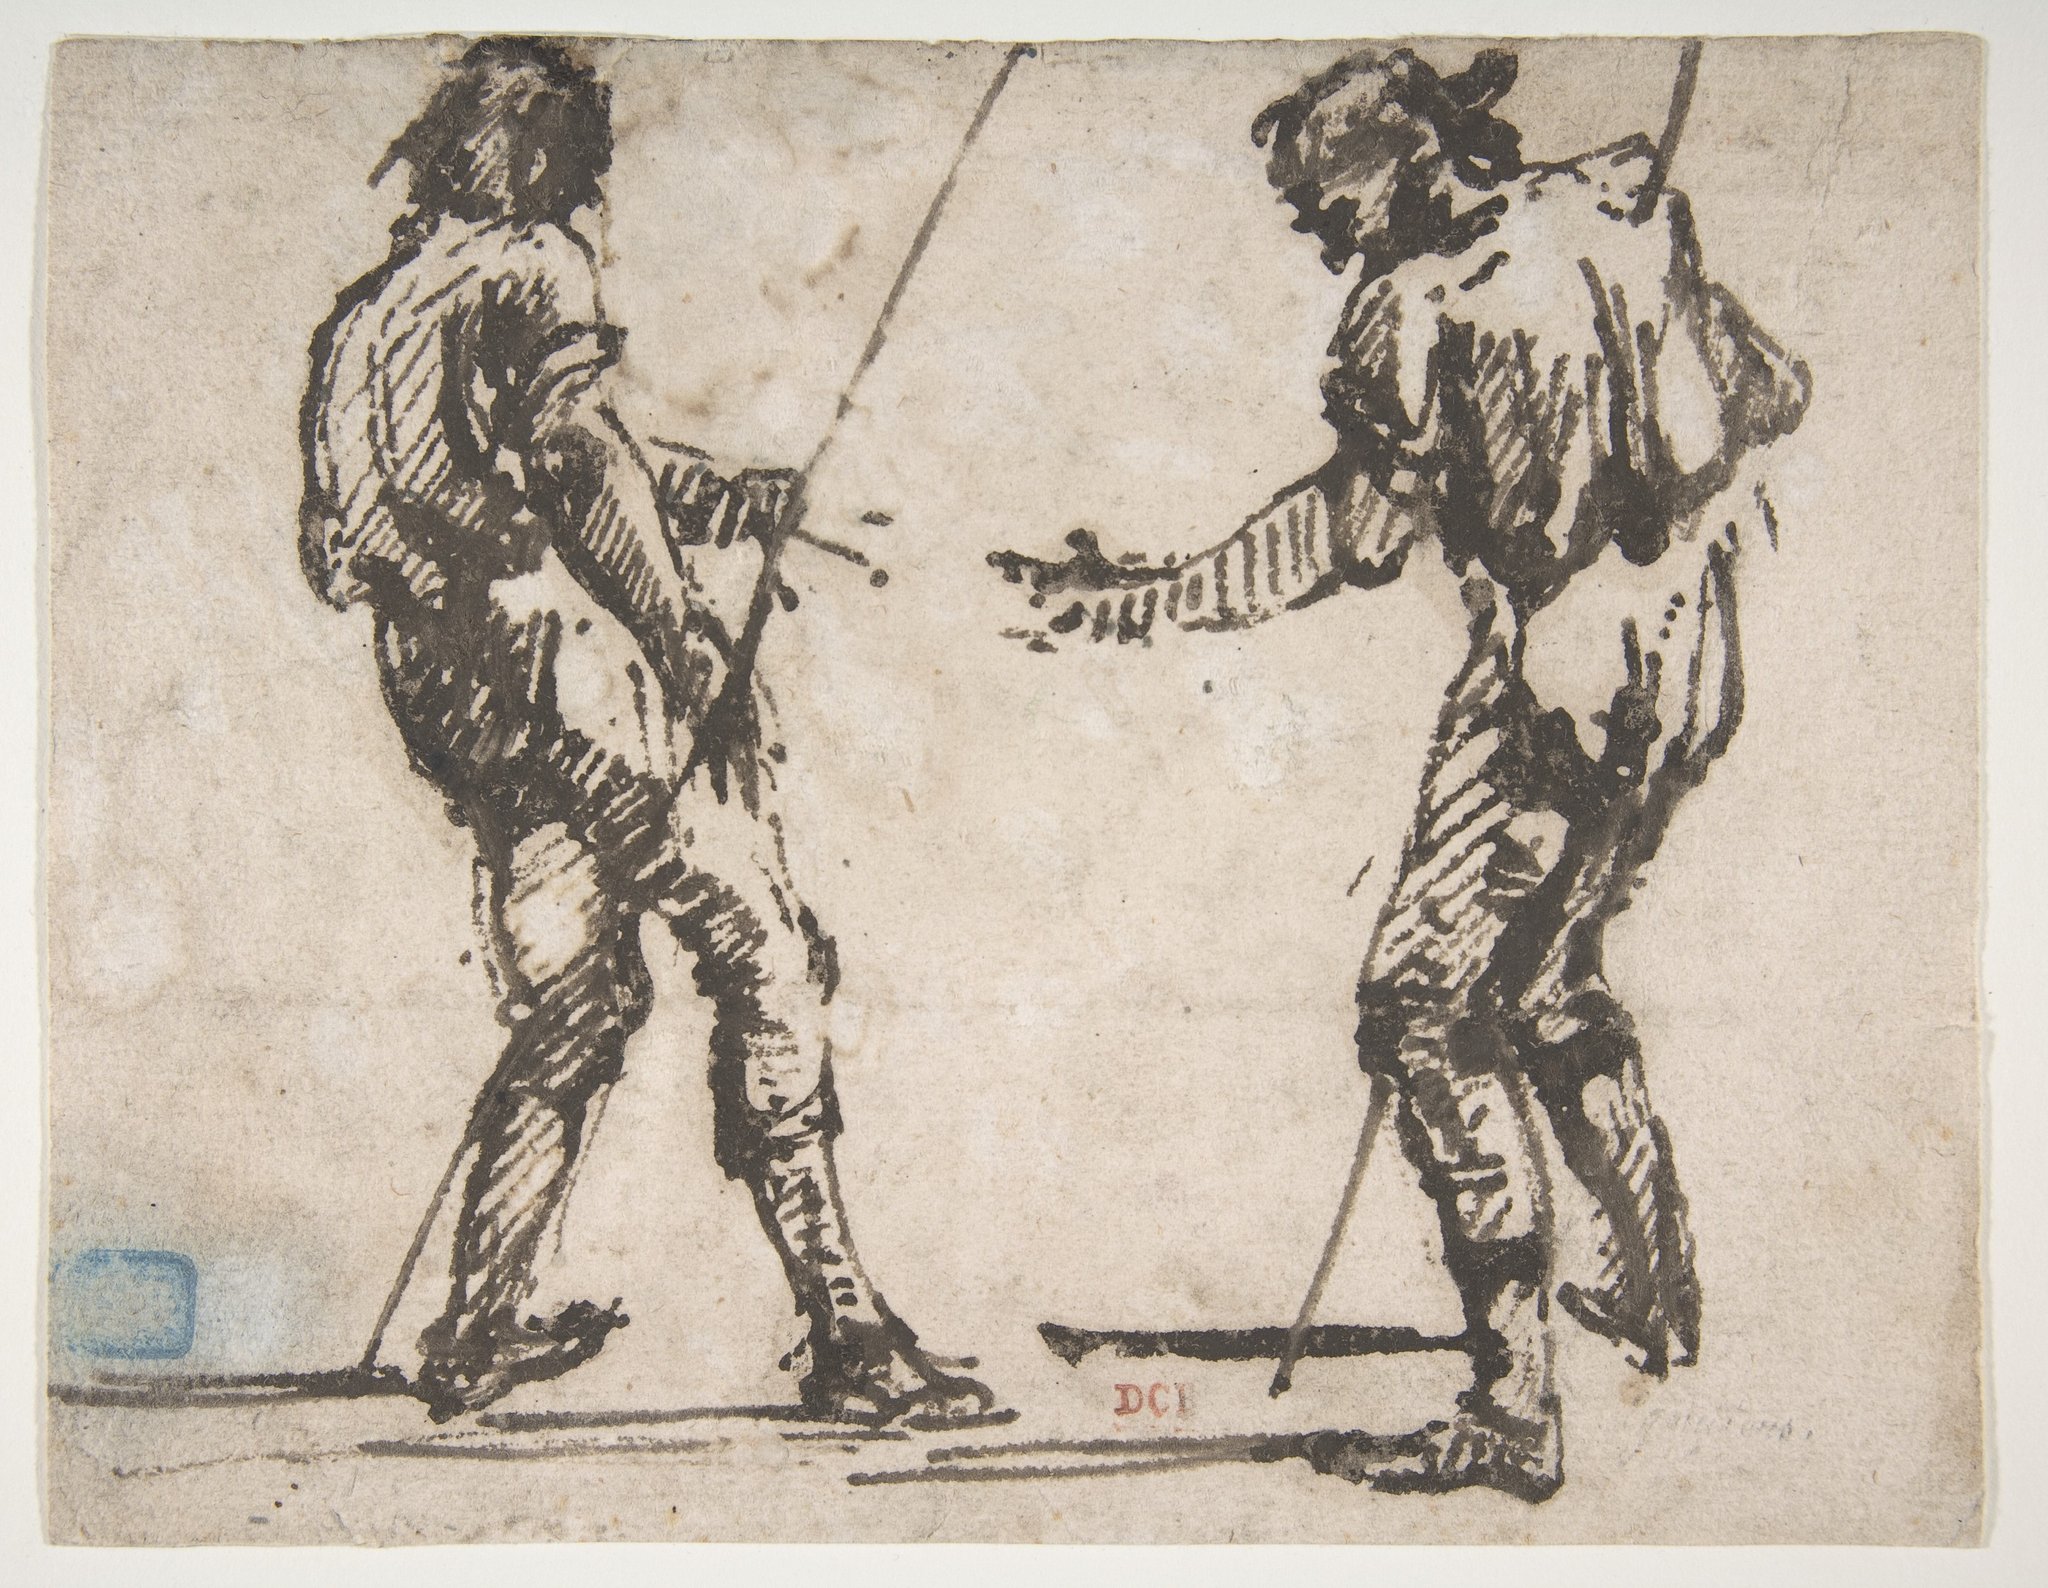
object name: drawing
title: Two Men Holding Long Staffs (recto); Proof impression of part of an etching, and scribbles in the artist's hand (verso)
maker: giovanni battista piranesi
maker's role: artist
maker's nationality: italian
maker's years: 1720-1778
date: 1720-1778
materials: ink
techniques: pen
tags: men